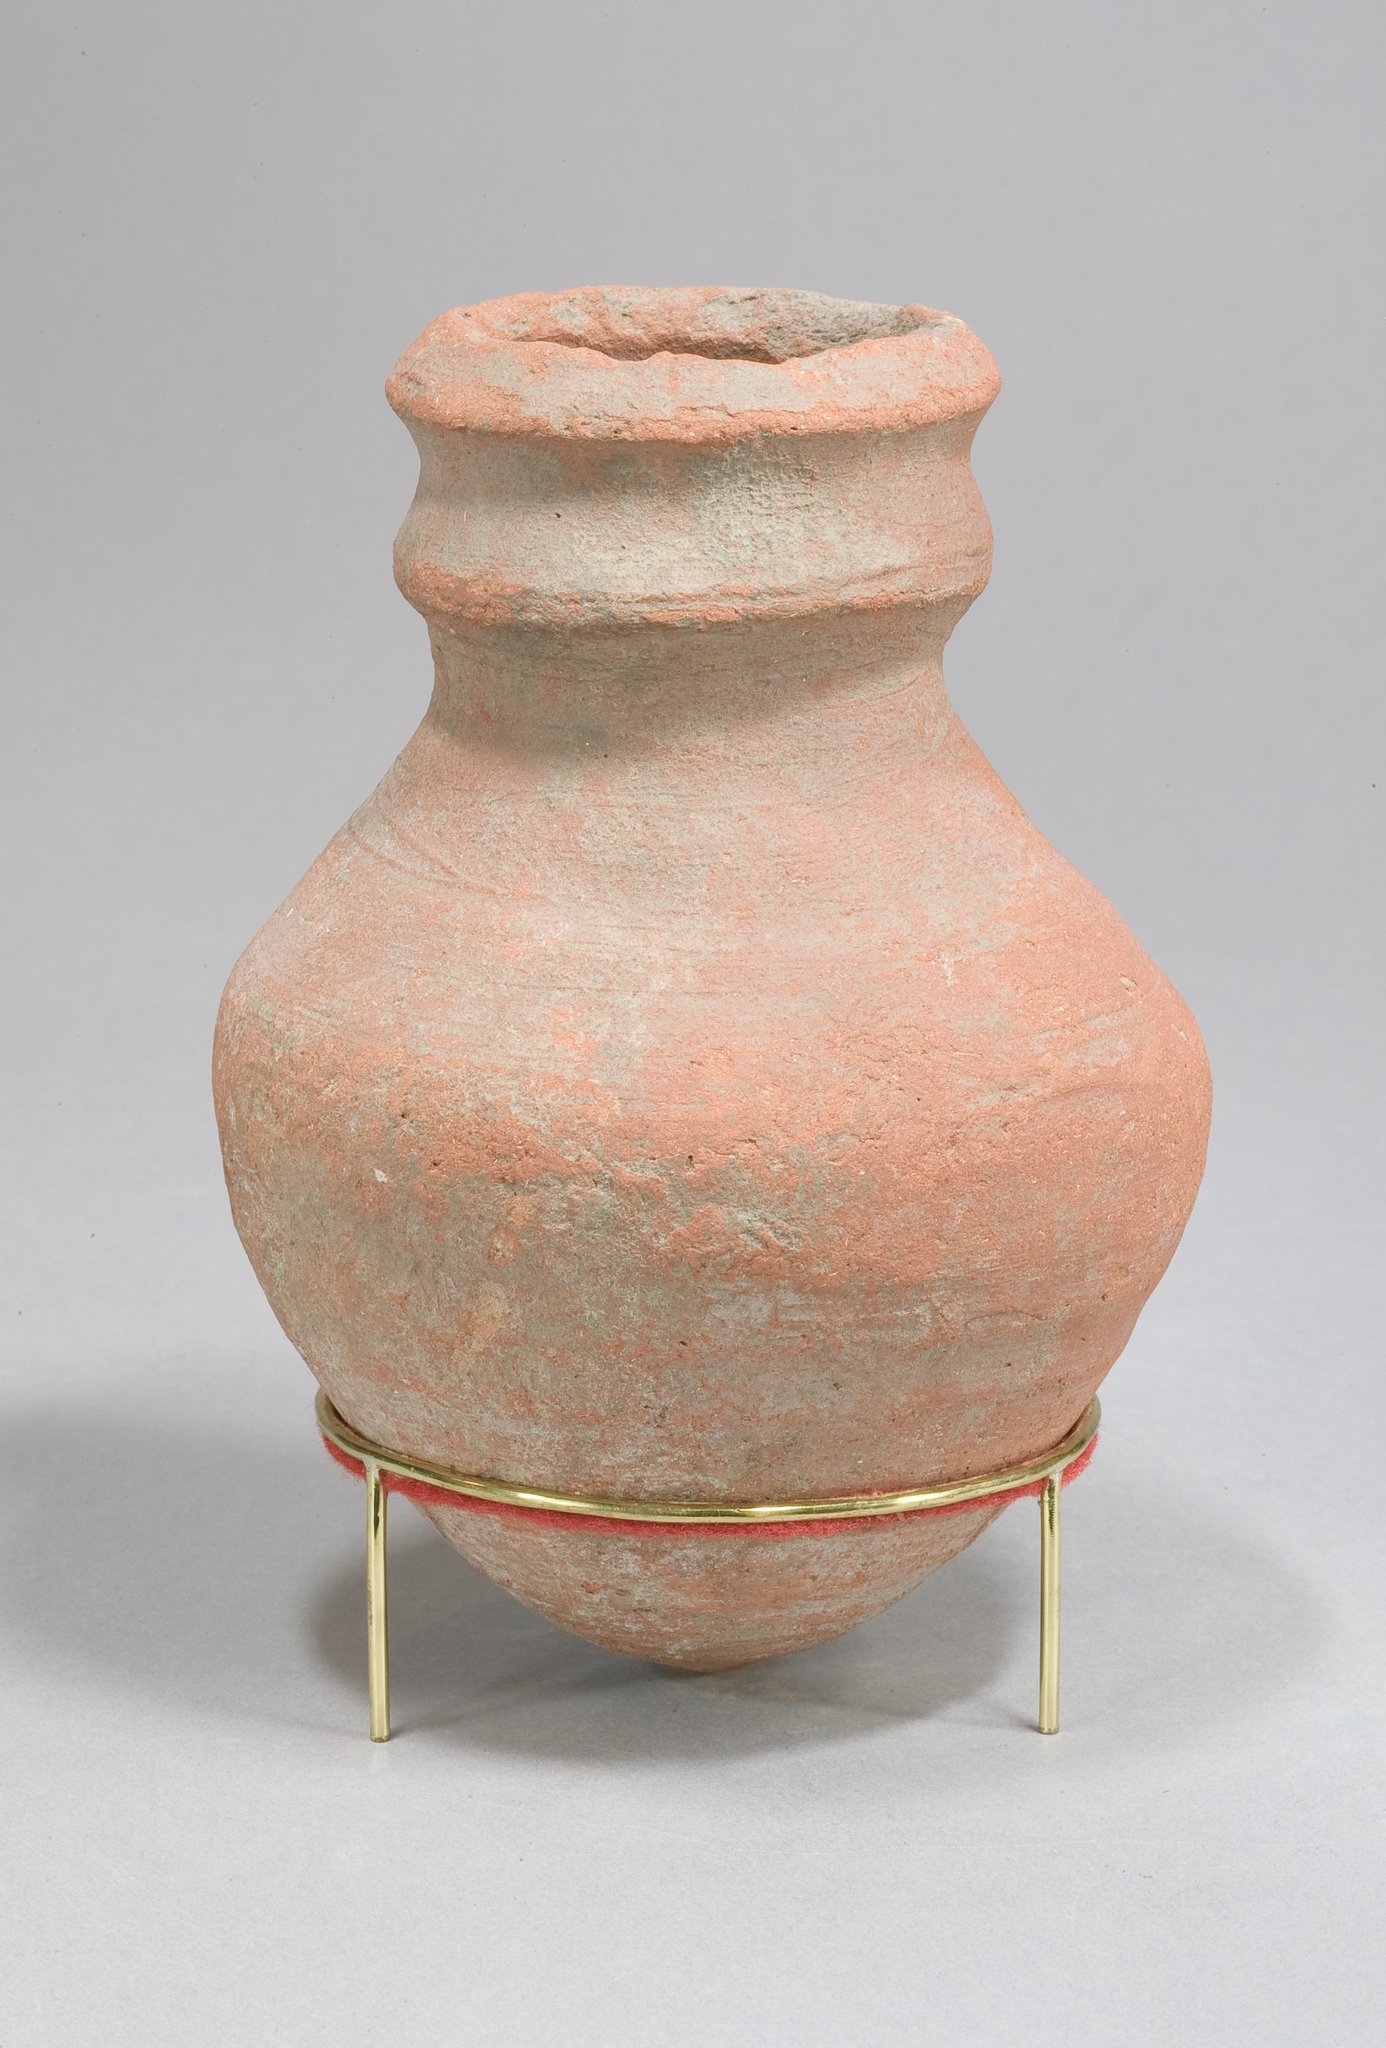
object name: jar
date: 1900-1640 BCE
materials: pottery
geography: egypt